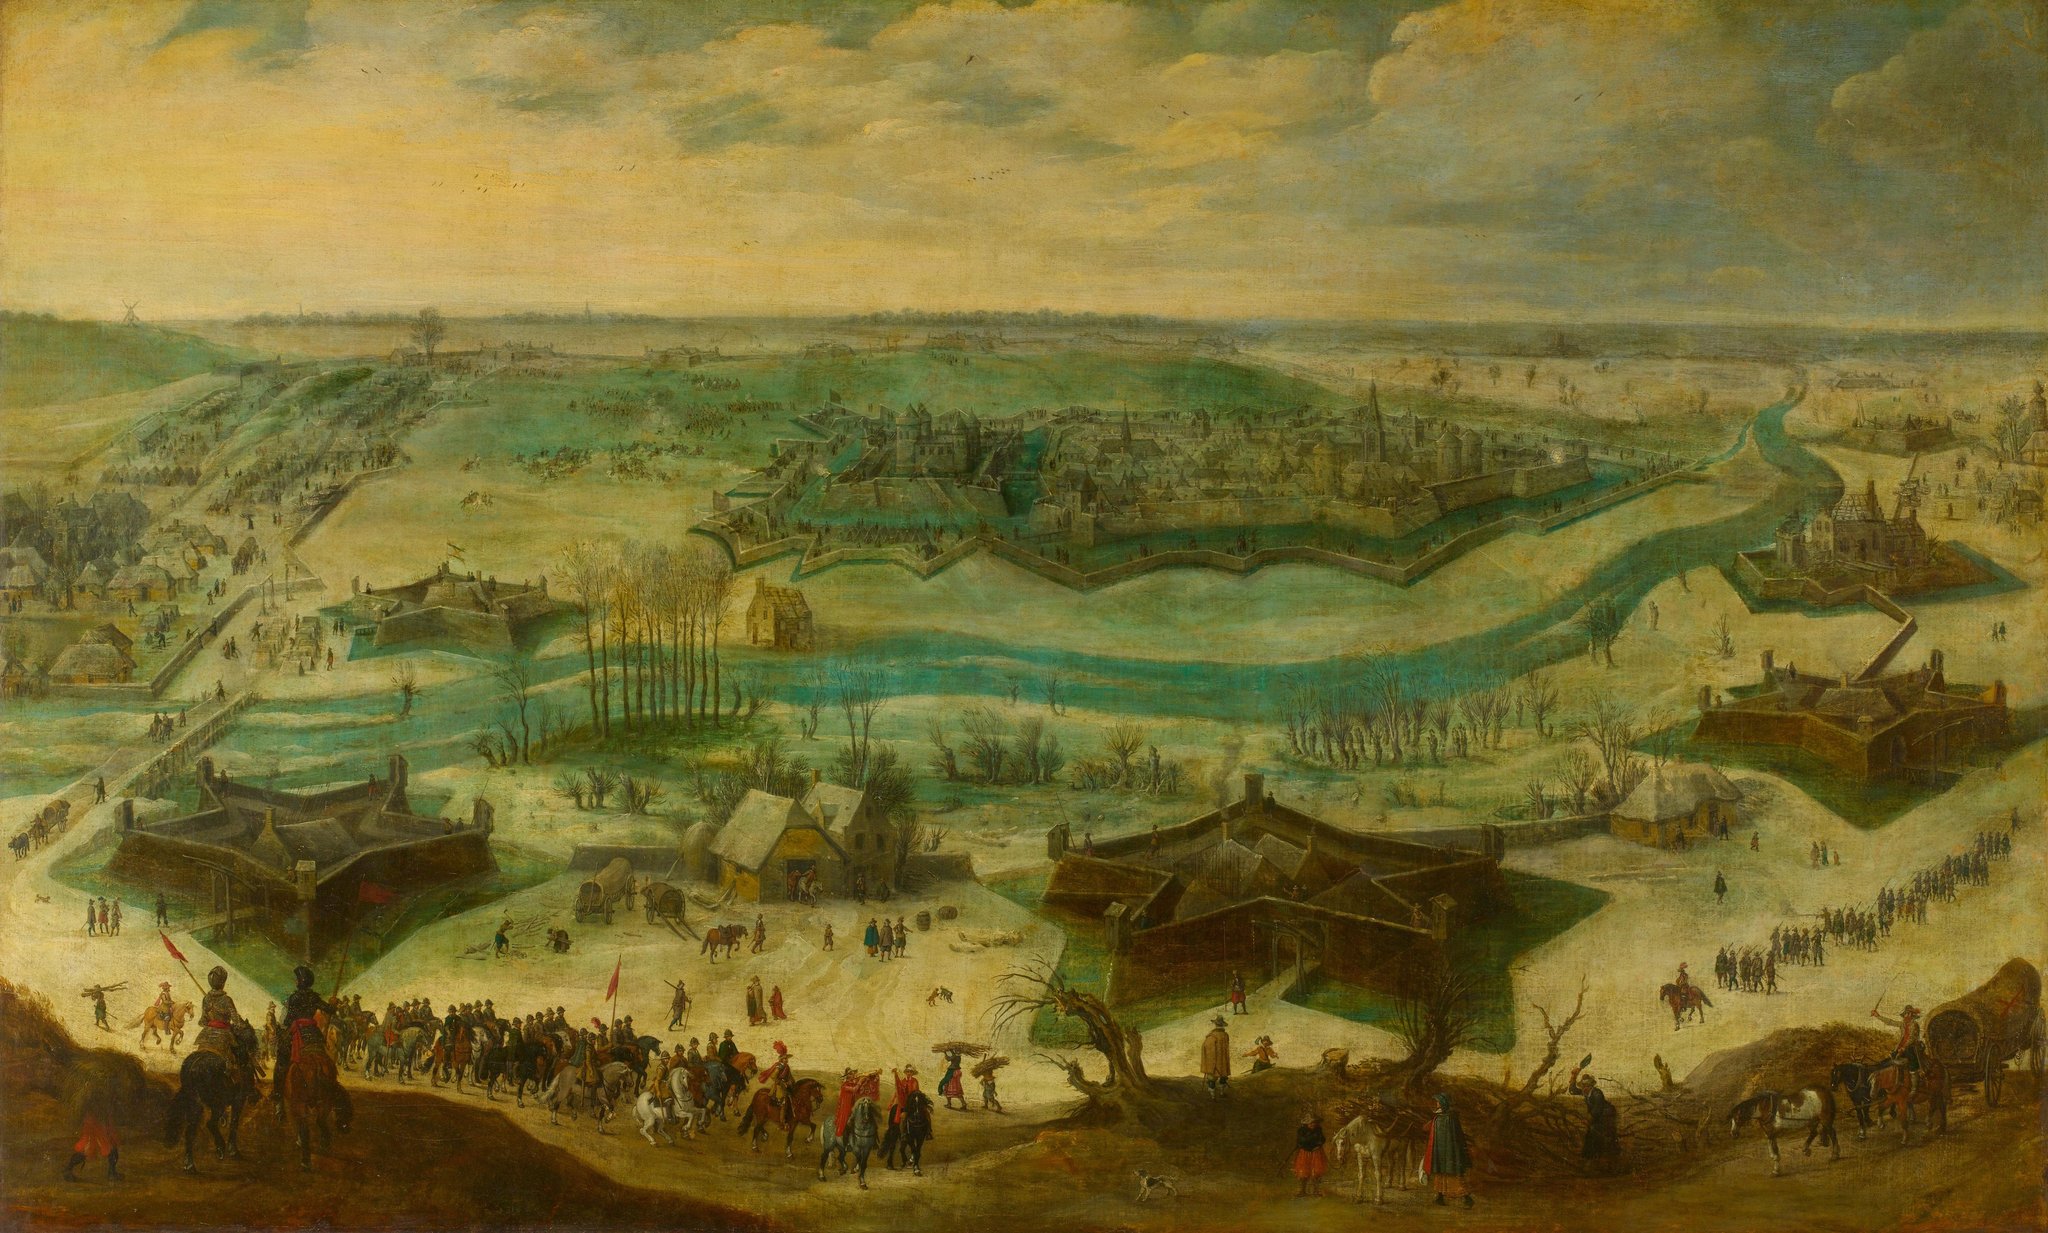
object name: painting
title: The Siege of Jülich, 1621-22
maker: sebastiaen vrancx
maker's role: draughtsman, painter, print maker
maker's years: 1573-1647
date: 1635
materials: canvas, oil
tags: siege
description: Het beleg van Gulik door de Spanjaarden onder Hendrik van den Bergh, tussen 5 september 1621 en 3 februari 1622. In het midden ligt de stad omgeven door vestingwerken, op de voorgrond een stoet ruiters en troepen van de belegeraars.